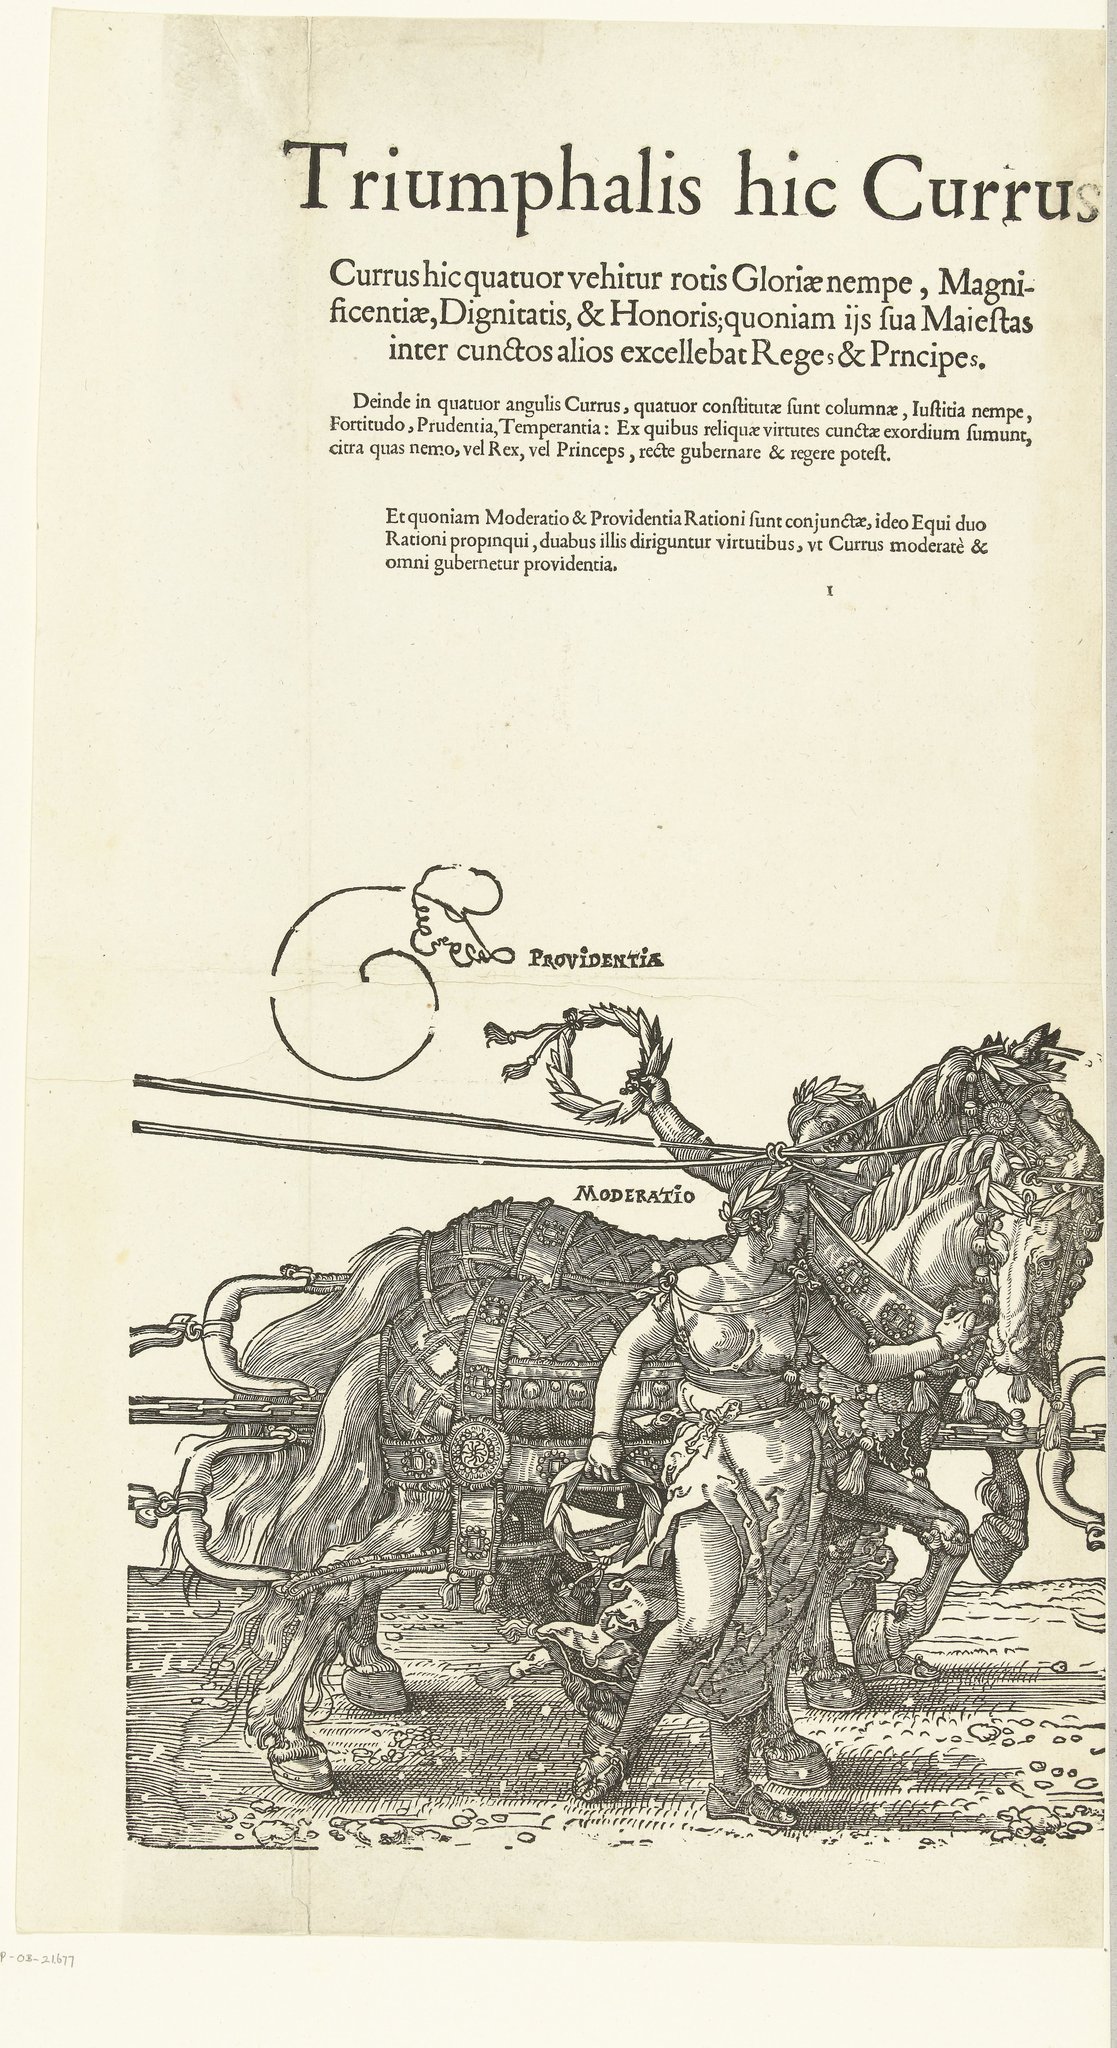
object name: print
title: Kopieën naar Dürers Triomfwagen voor keizer Maximiliaan I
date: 1527-1529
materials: paper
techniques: letterpress printing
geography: amsterdam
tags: maximilian i (holy roman emperor), chariot, triumphal car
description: De grote triomfwagen ter ere van keizer Maximiliaan I bij zijn overlijden op 12 januari 1519. Derde blad met het eerste span paarden met Providentia en Moderatio.